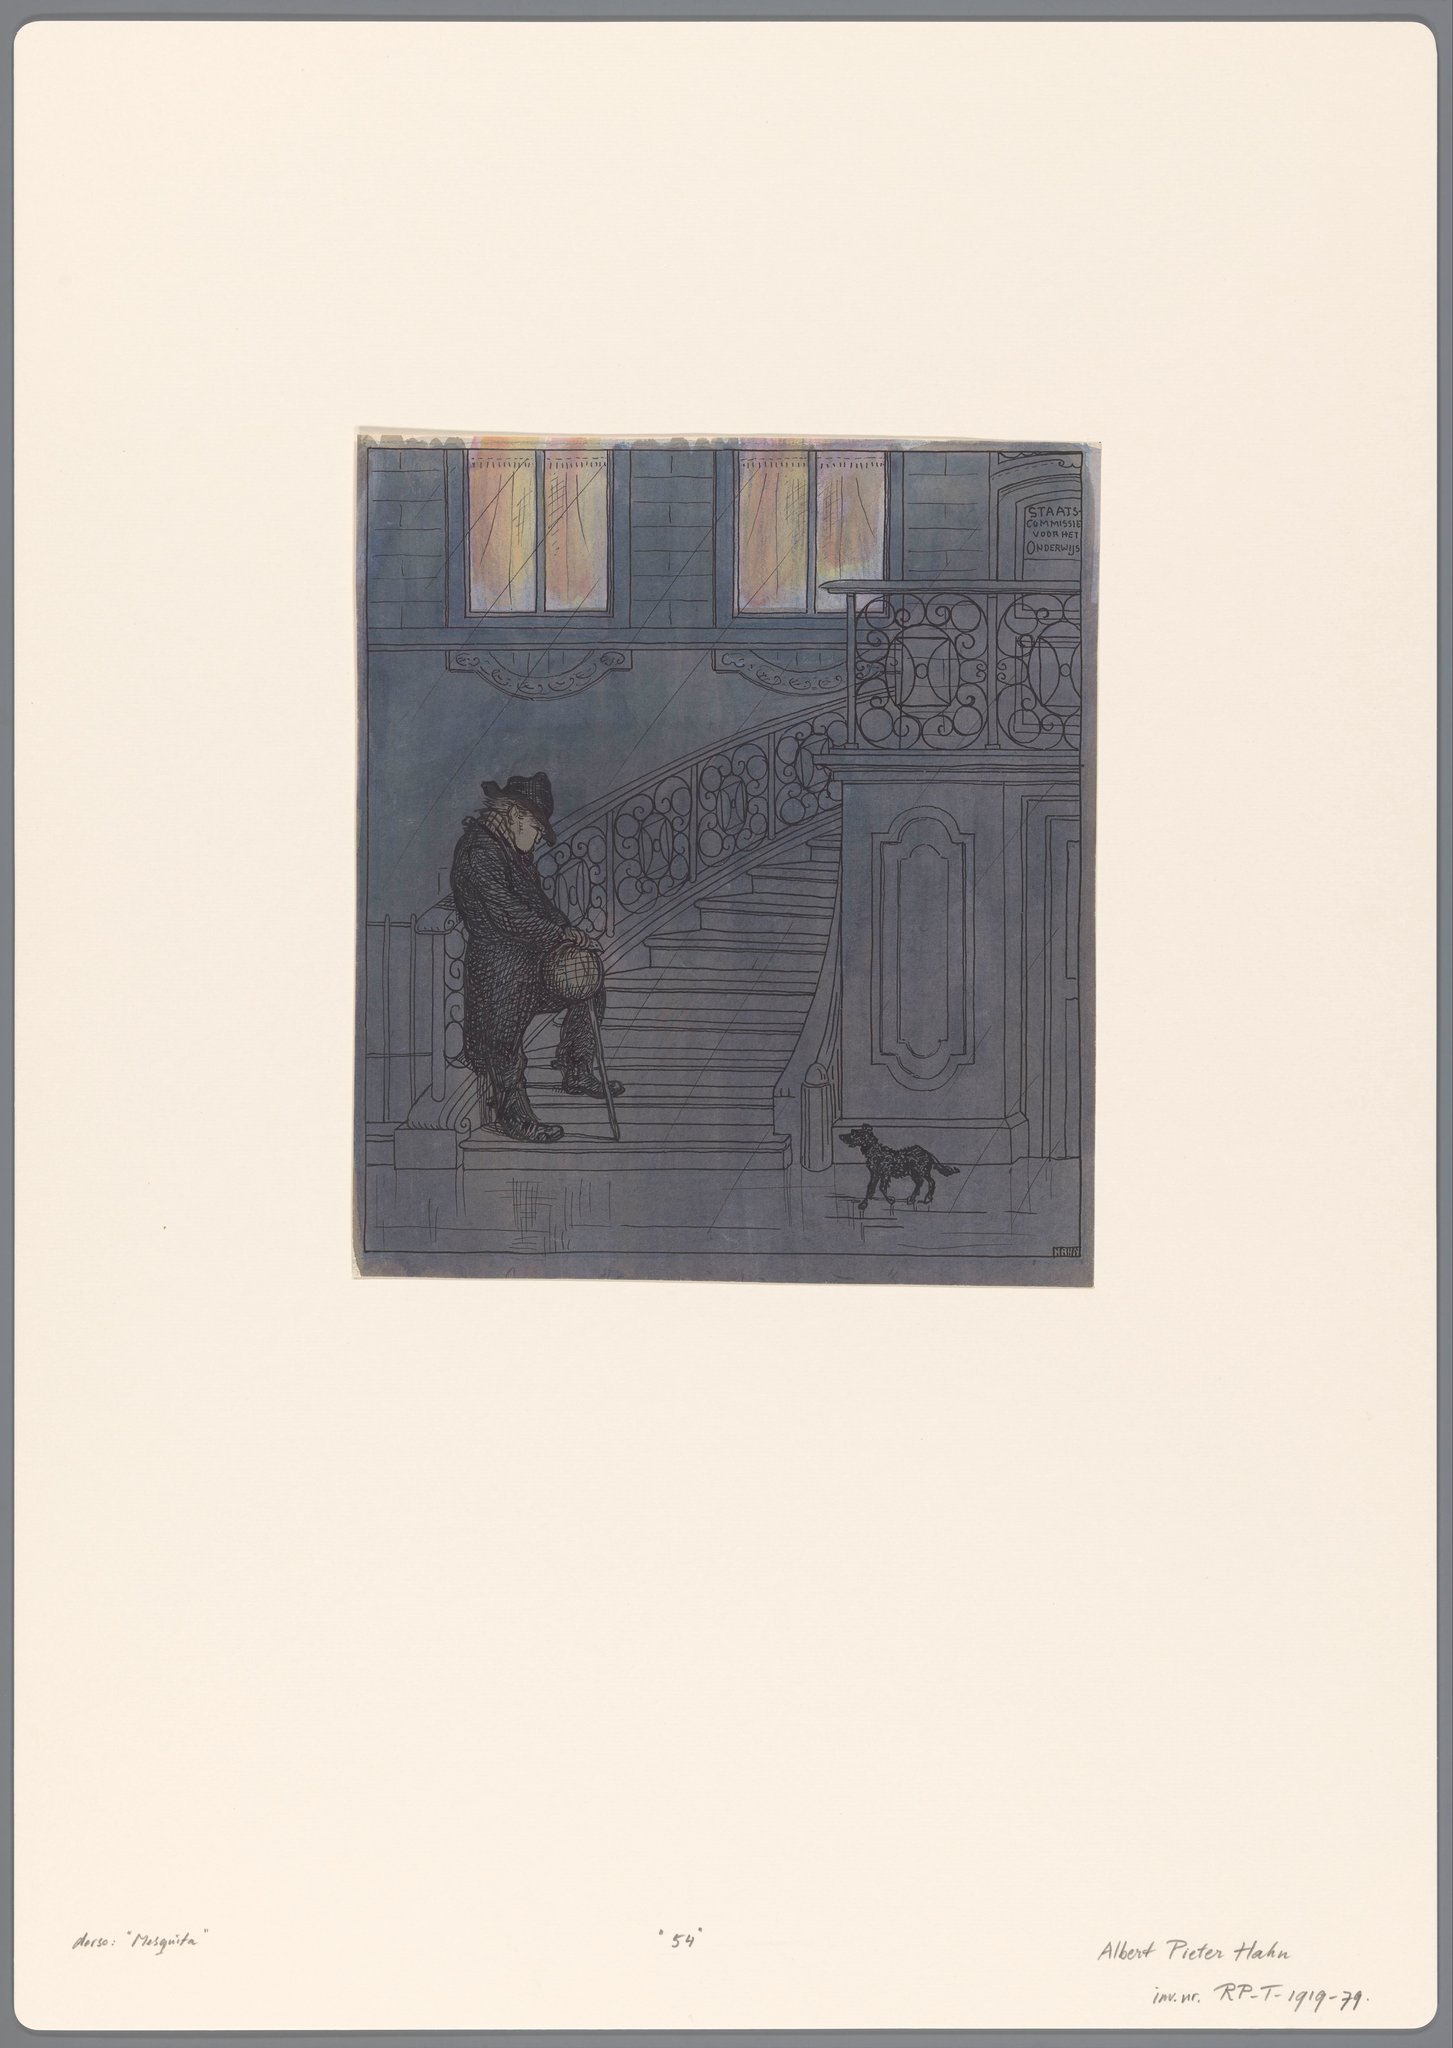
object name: drawing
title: Ontwerp voor een politieke spotprent: de Staatscommissie voor het Onderwijs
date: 1887-1919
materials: chalk, ink, paper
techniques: brush, pen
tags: symbolic representations, allegories and emblems ~ education; 'ammaestramento', dottrina', 'educatione', 'istitutione' (ripa), political caricatures and satires